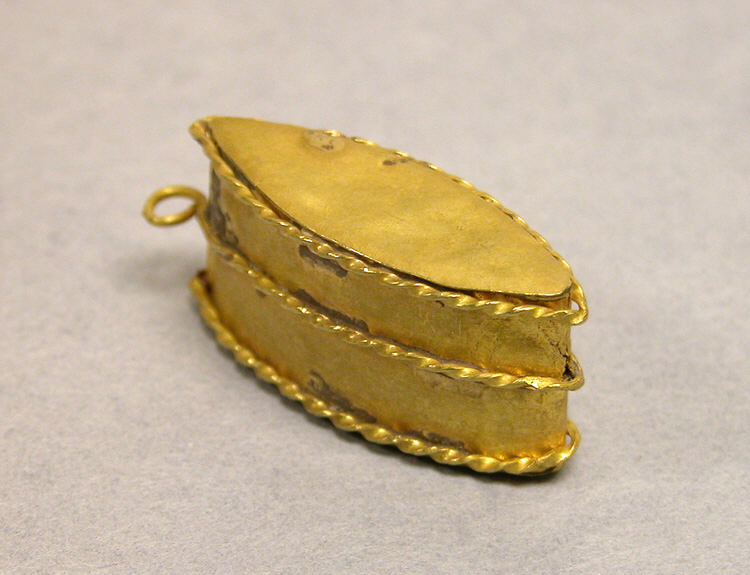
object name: necklace, bead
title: Amulet, Waisted by Triple Wire Twist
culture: indonesian, central java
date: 701-1200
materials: gold